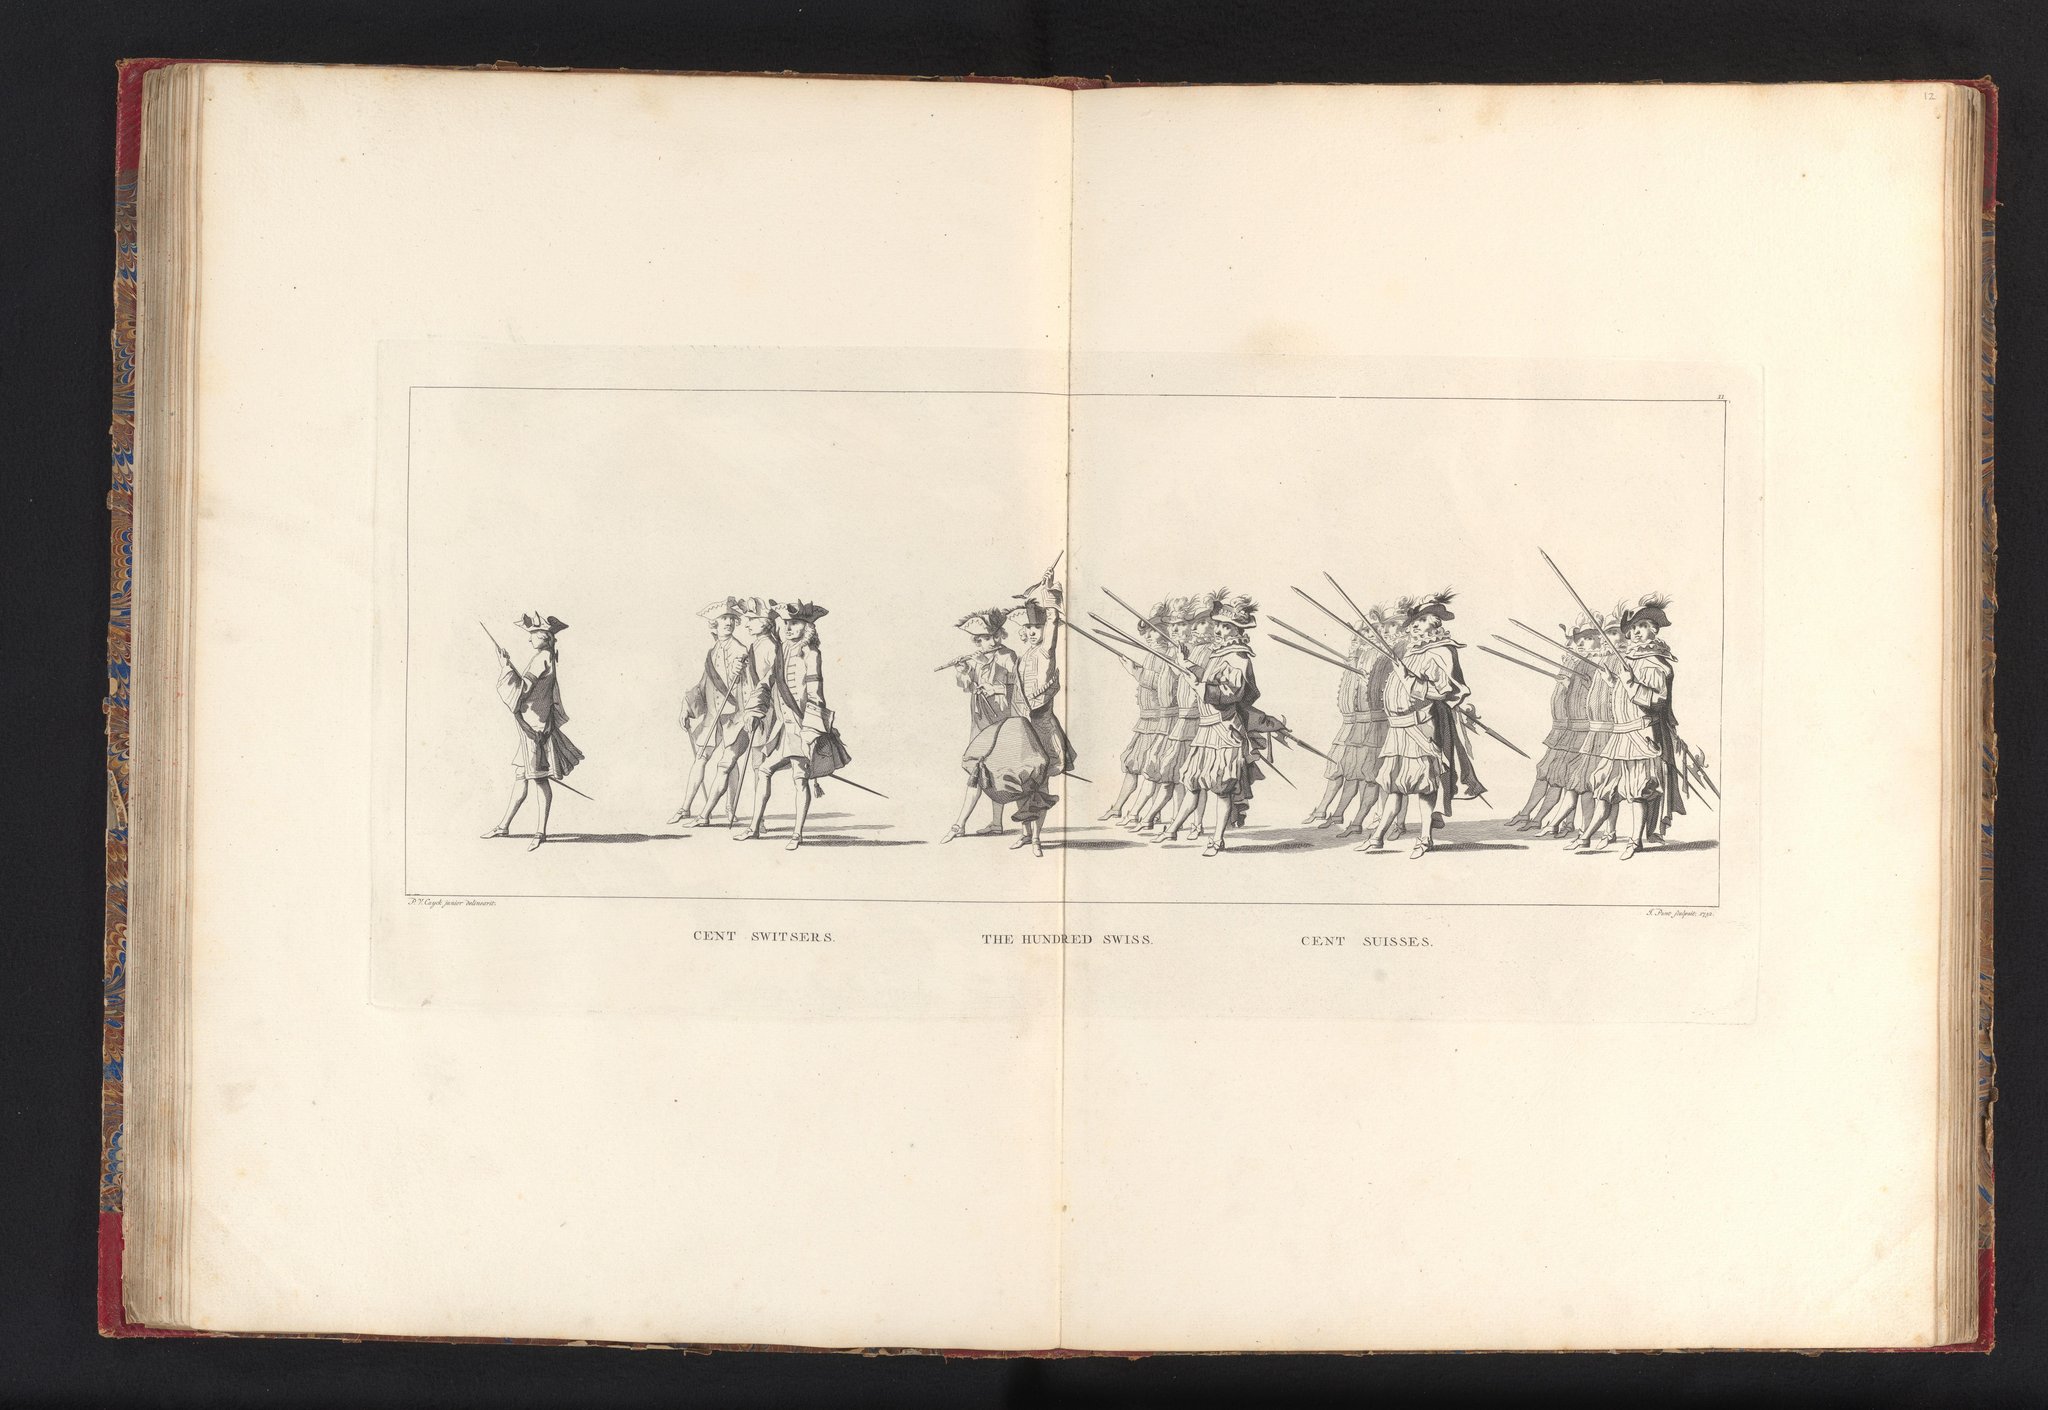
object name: print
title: Lyk-staetsie van zyne doorluchtigste Hoogheid den Heere Willem Carel Hendrik Friso, Prince van Orange en Nassau (...) gehouden den IV Februari 1752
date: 1752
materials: paper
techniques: engraving, etching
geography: the hague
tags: the hague, willem iv (prins van oranje-nassau), military parade, pageant (+ infantry), cortege, funeral procession, delft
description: De Cent-Suisses. In de marge een onderschrift in het Nederlands, Frans en Engels. De prent maakt deel uit van een album.